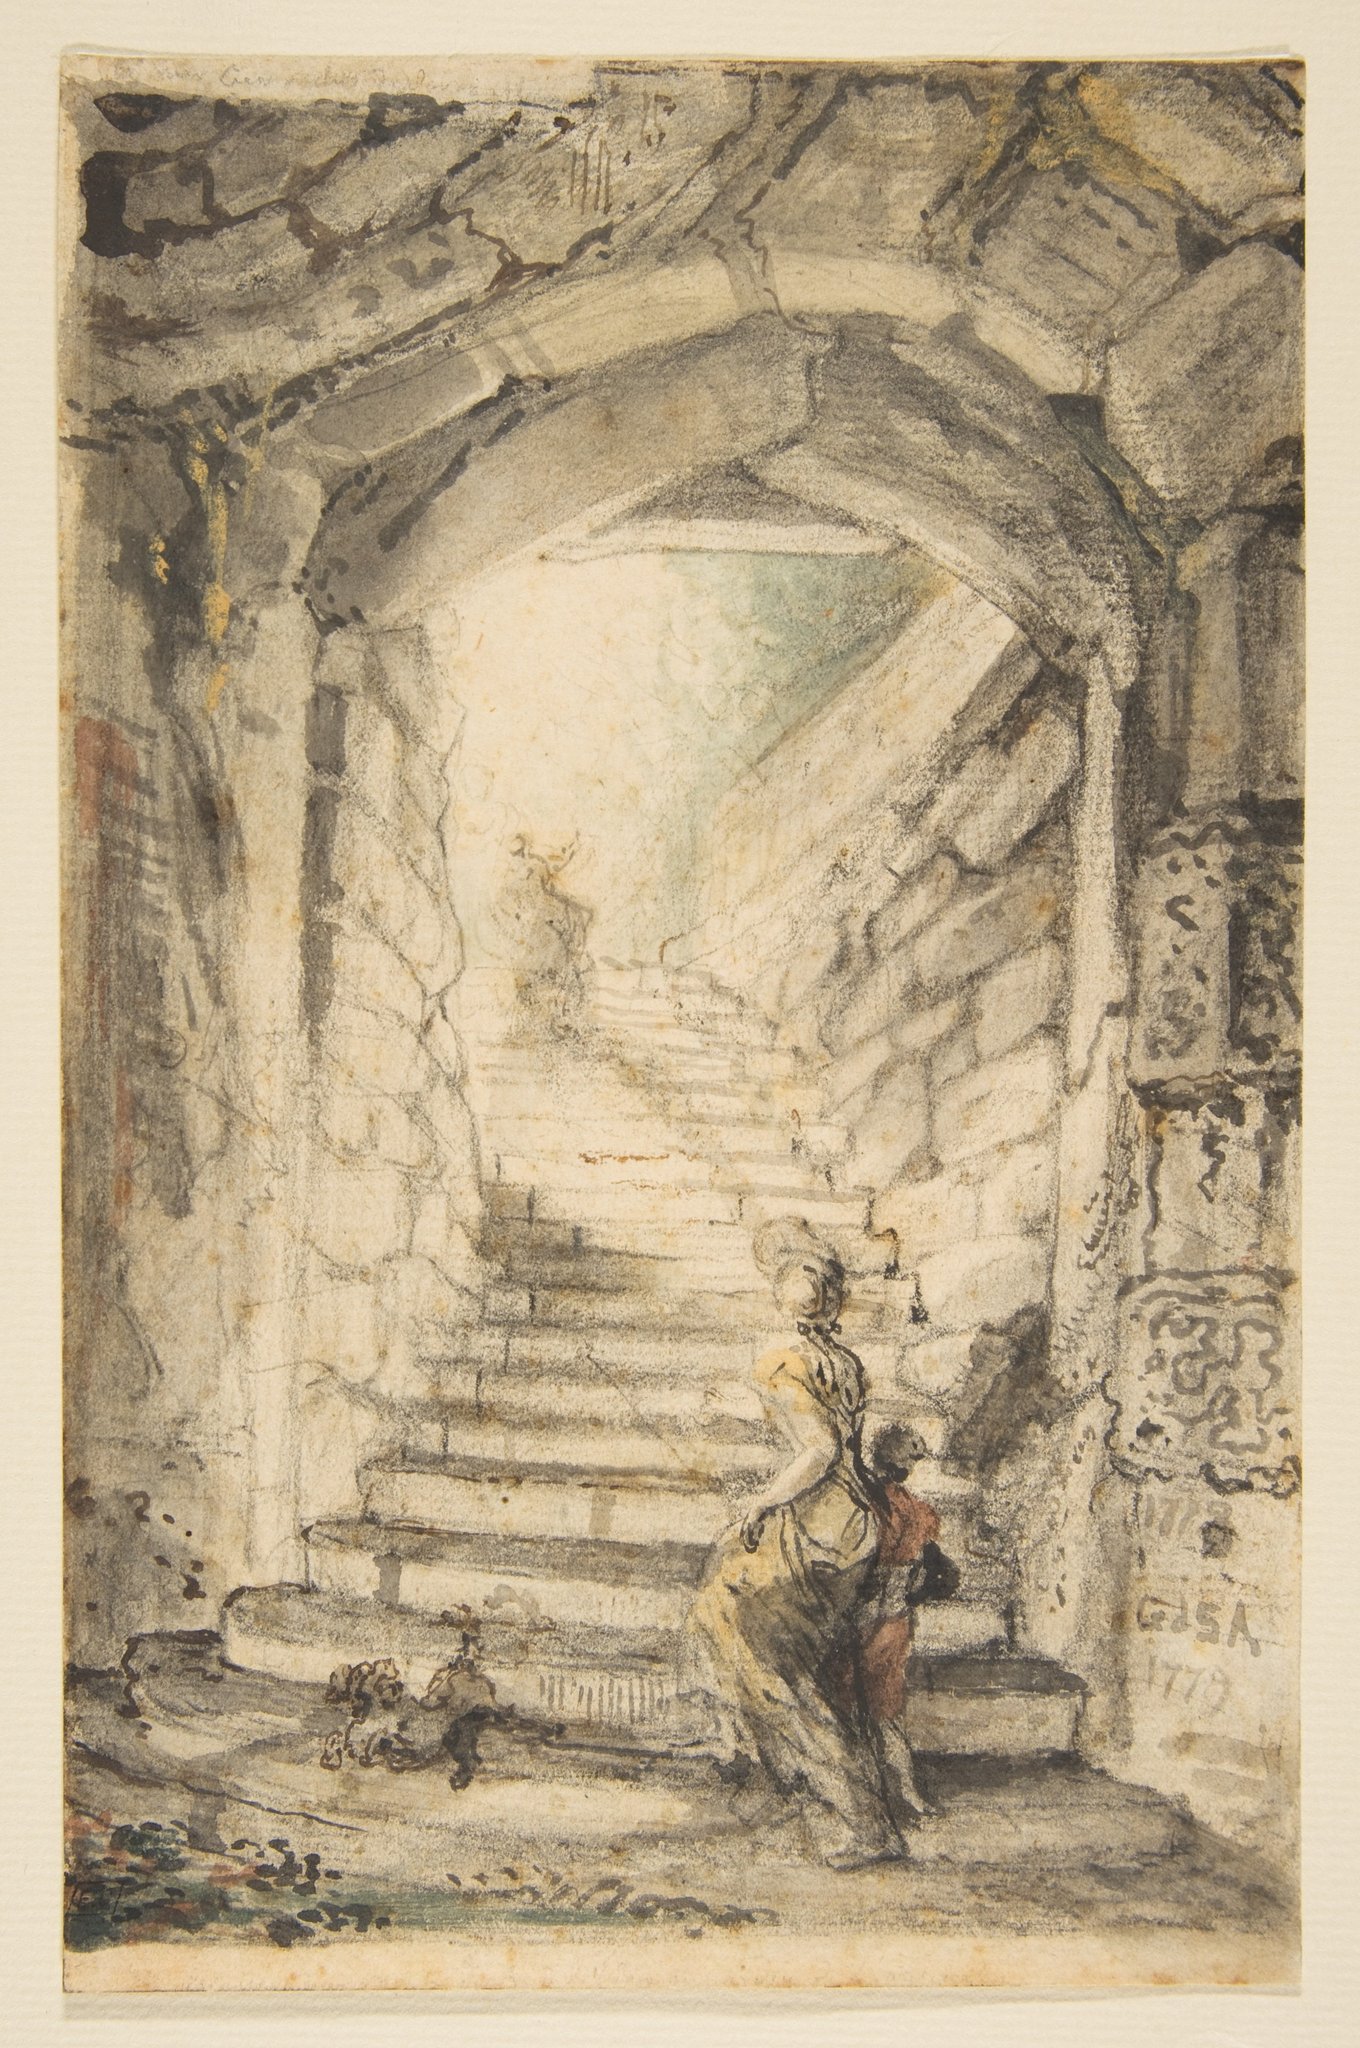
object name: drawing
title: The Curving Stair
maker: gabriel de saint-aubin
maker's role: artist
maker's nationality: french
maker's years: 1724-1780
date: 1778-1779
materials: chalk, gouache, ink, paper, watercolor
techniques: pen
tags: stairs,women